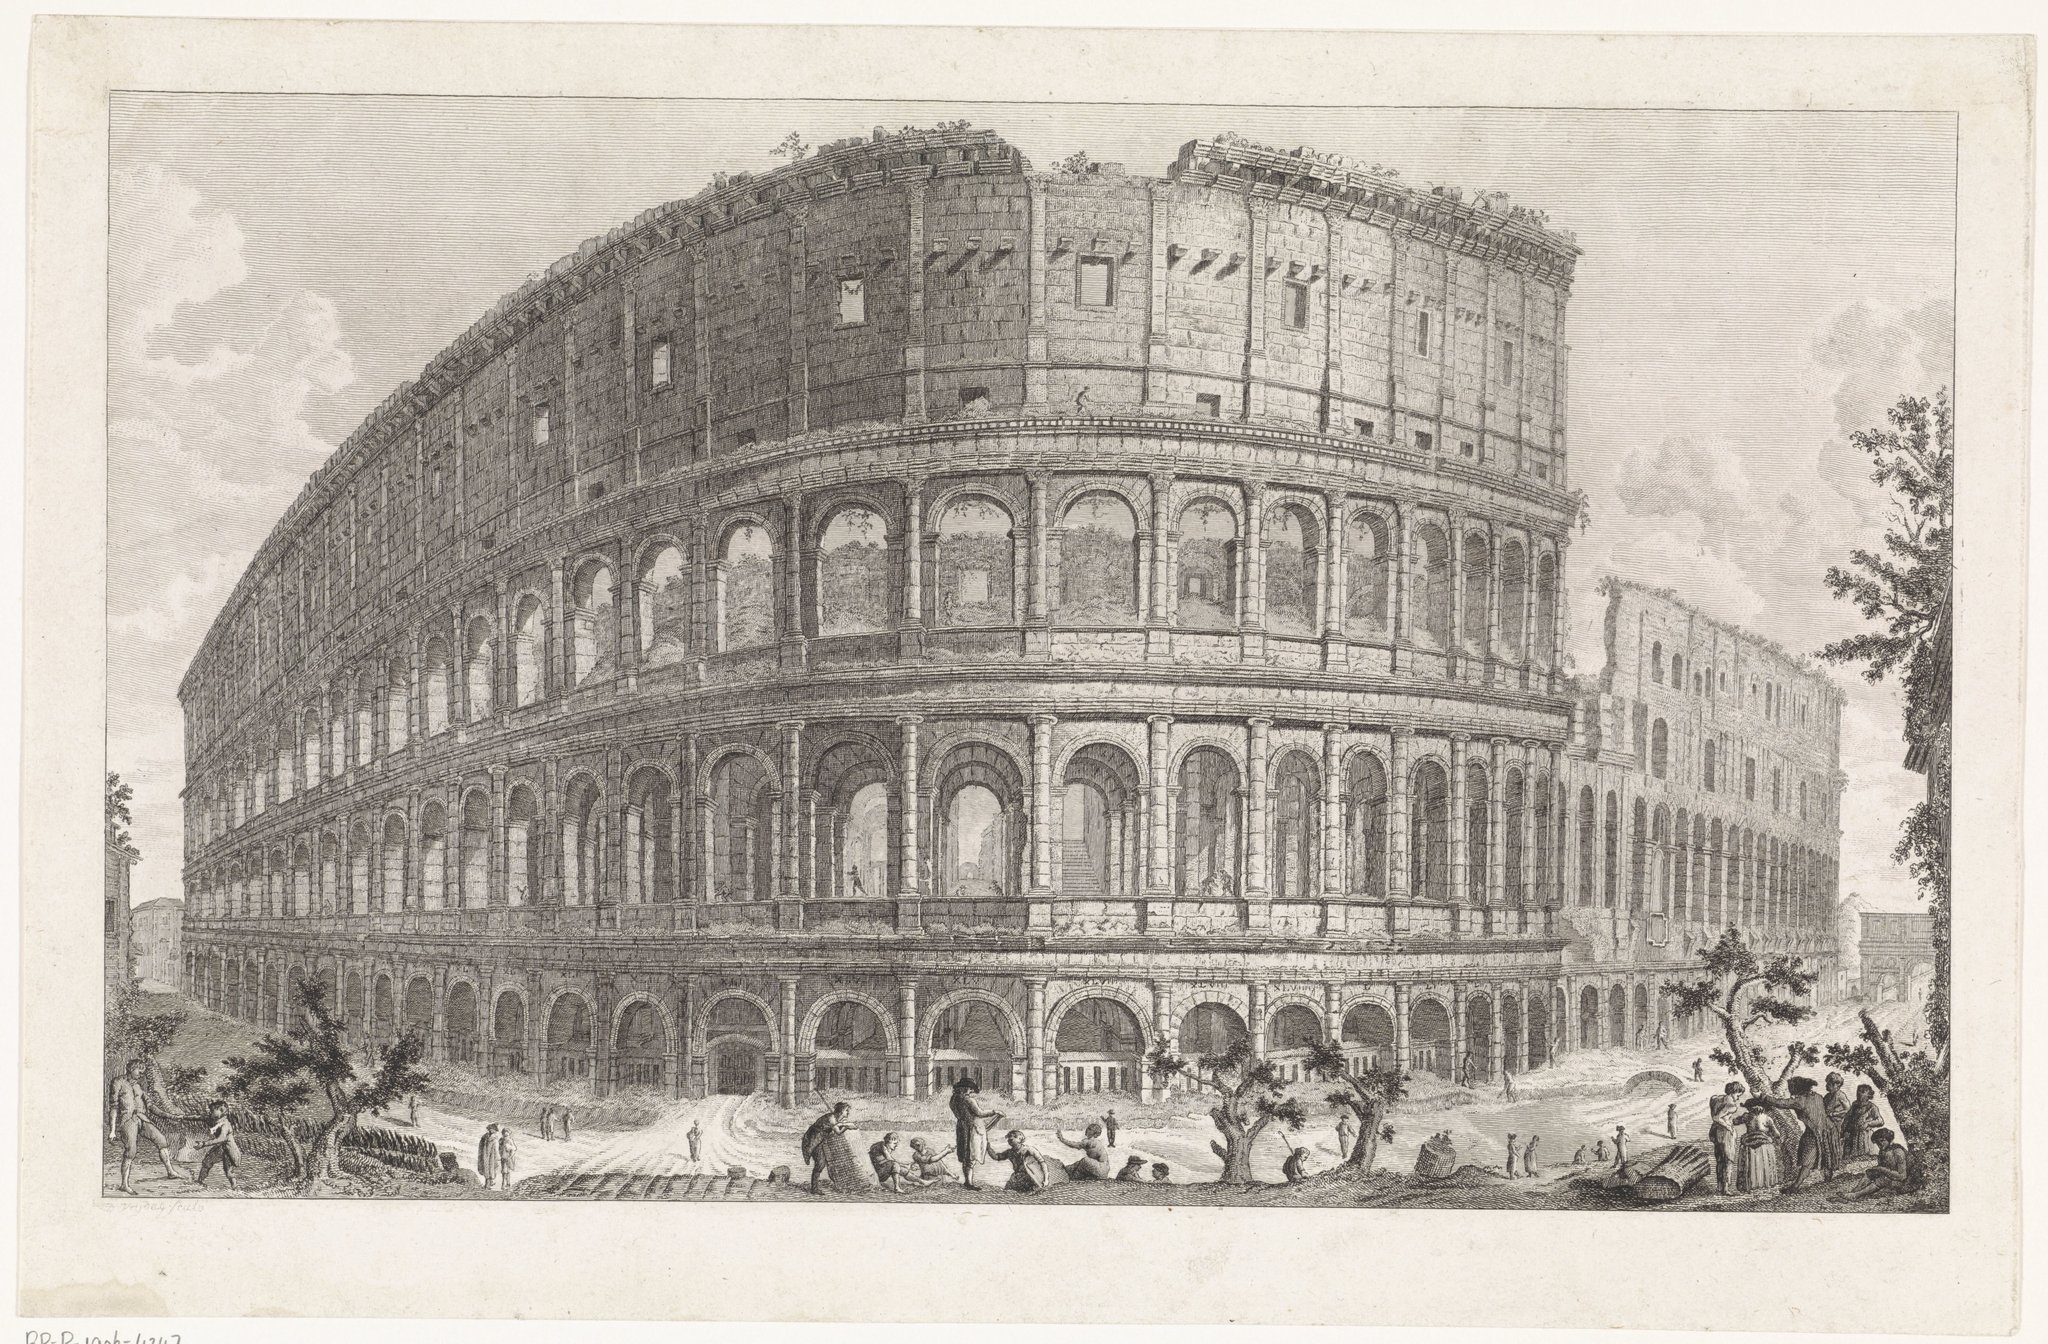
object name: print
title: Gezicht op het Colosseum te Rome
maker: daniël vrijdag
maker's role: draughtsman, print maker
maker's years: 1765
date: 1799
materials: paper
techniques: etching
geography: amsterdam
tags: colosseum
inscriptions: collector's mark: Lugt 2228, collector's mark: Lugt 2028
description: De definitieve staat van deze prent is gebruikt als illustratie in: Stolberg, graaf Friedrich Leopold zu. Reis door Duitschland, Zwitserland, Italie en Sicilie, deel II, p. 142. Amsterdam: Johannes Allart, 1799.